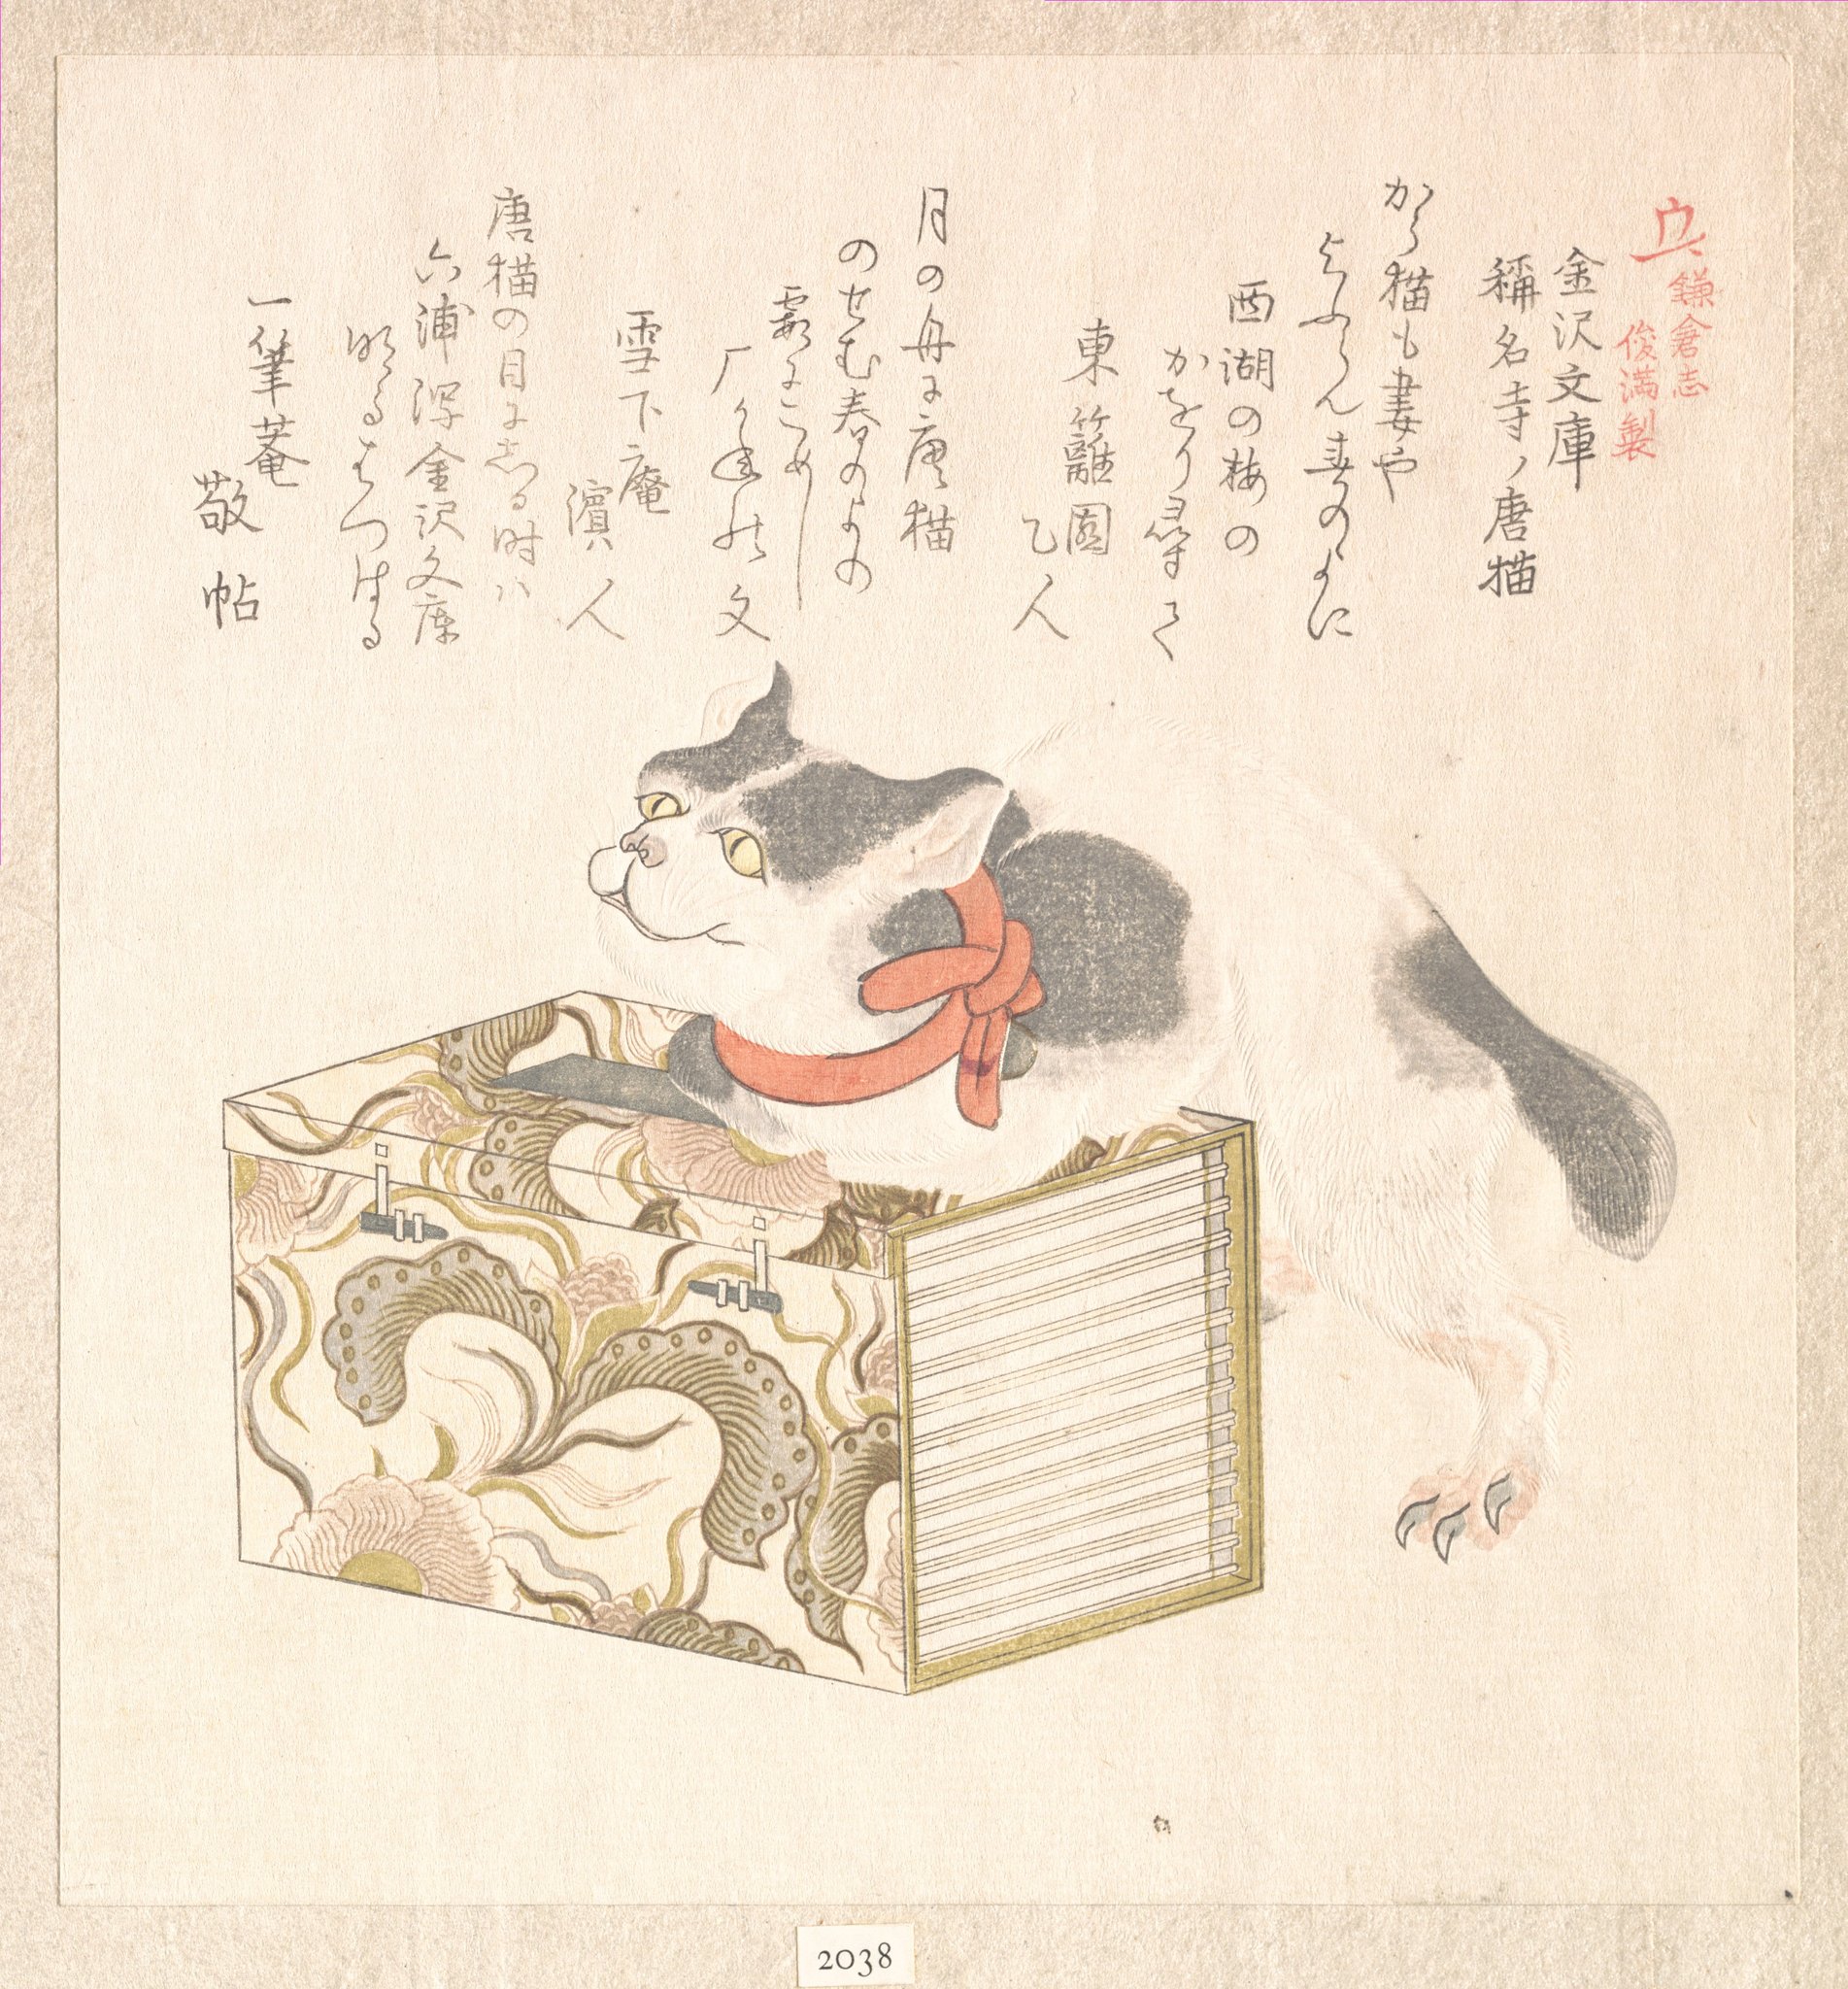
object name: woodblock print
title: Spring Rain Collection (Harusame shū), vol. 1: “Books from Kanazawa Library” (Kanazawa Bunko) and “Foreign Cat of Shōmyōji Temple” (Shōmyōji no kara neko), from the series History of Kamakura (Kamakura shi)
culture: japanese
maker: kubo shunman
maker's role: artist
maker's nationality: japanese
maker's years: 1757-1820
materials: ink, paper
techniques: surimono, woodblock print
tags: animals